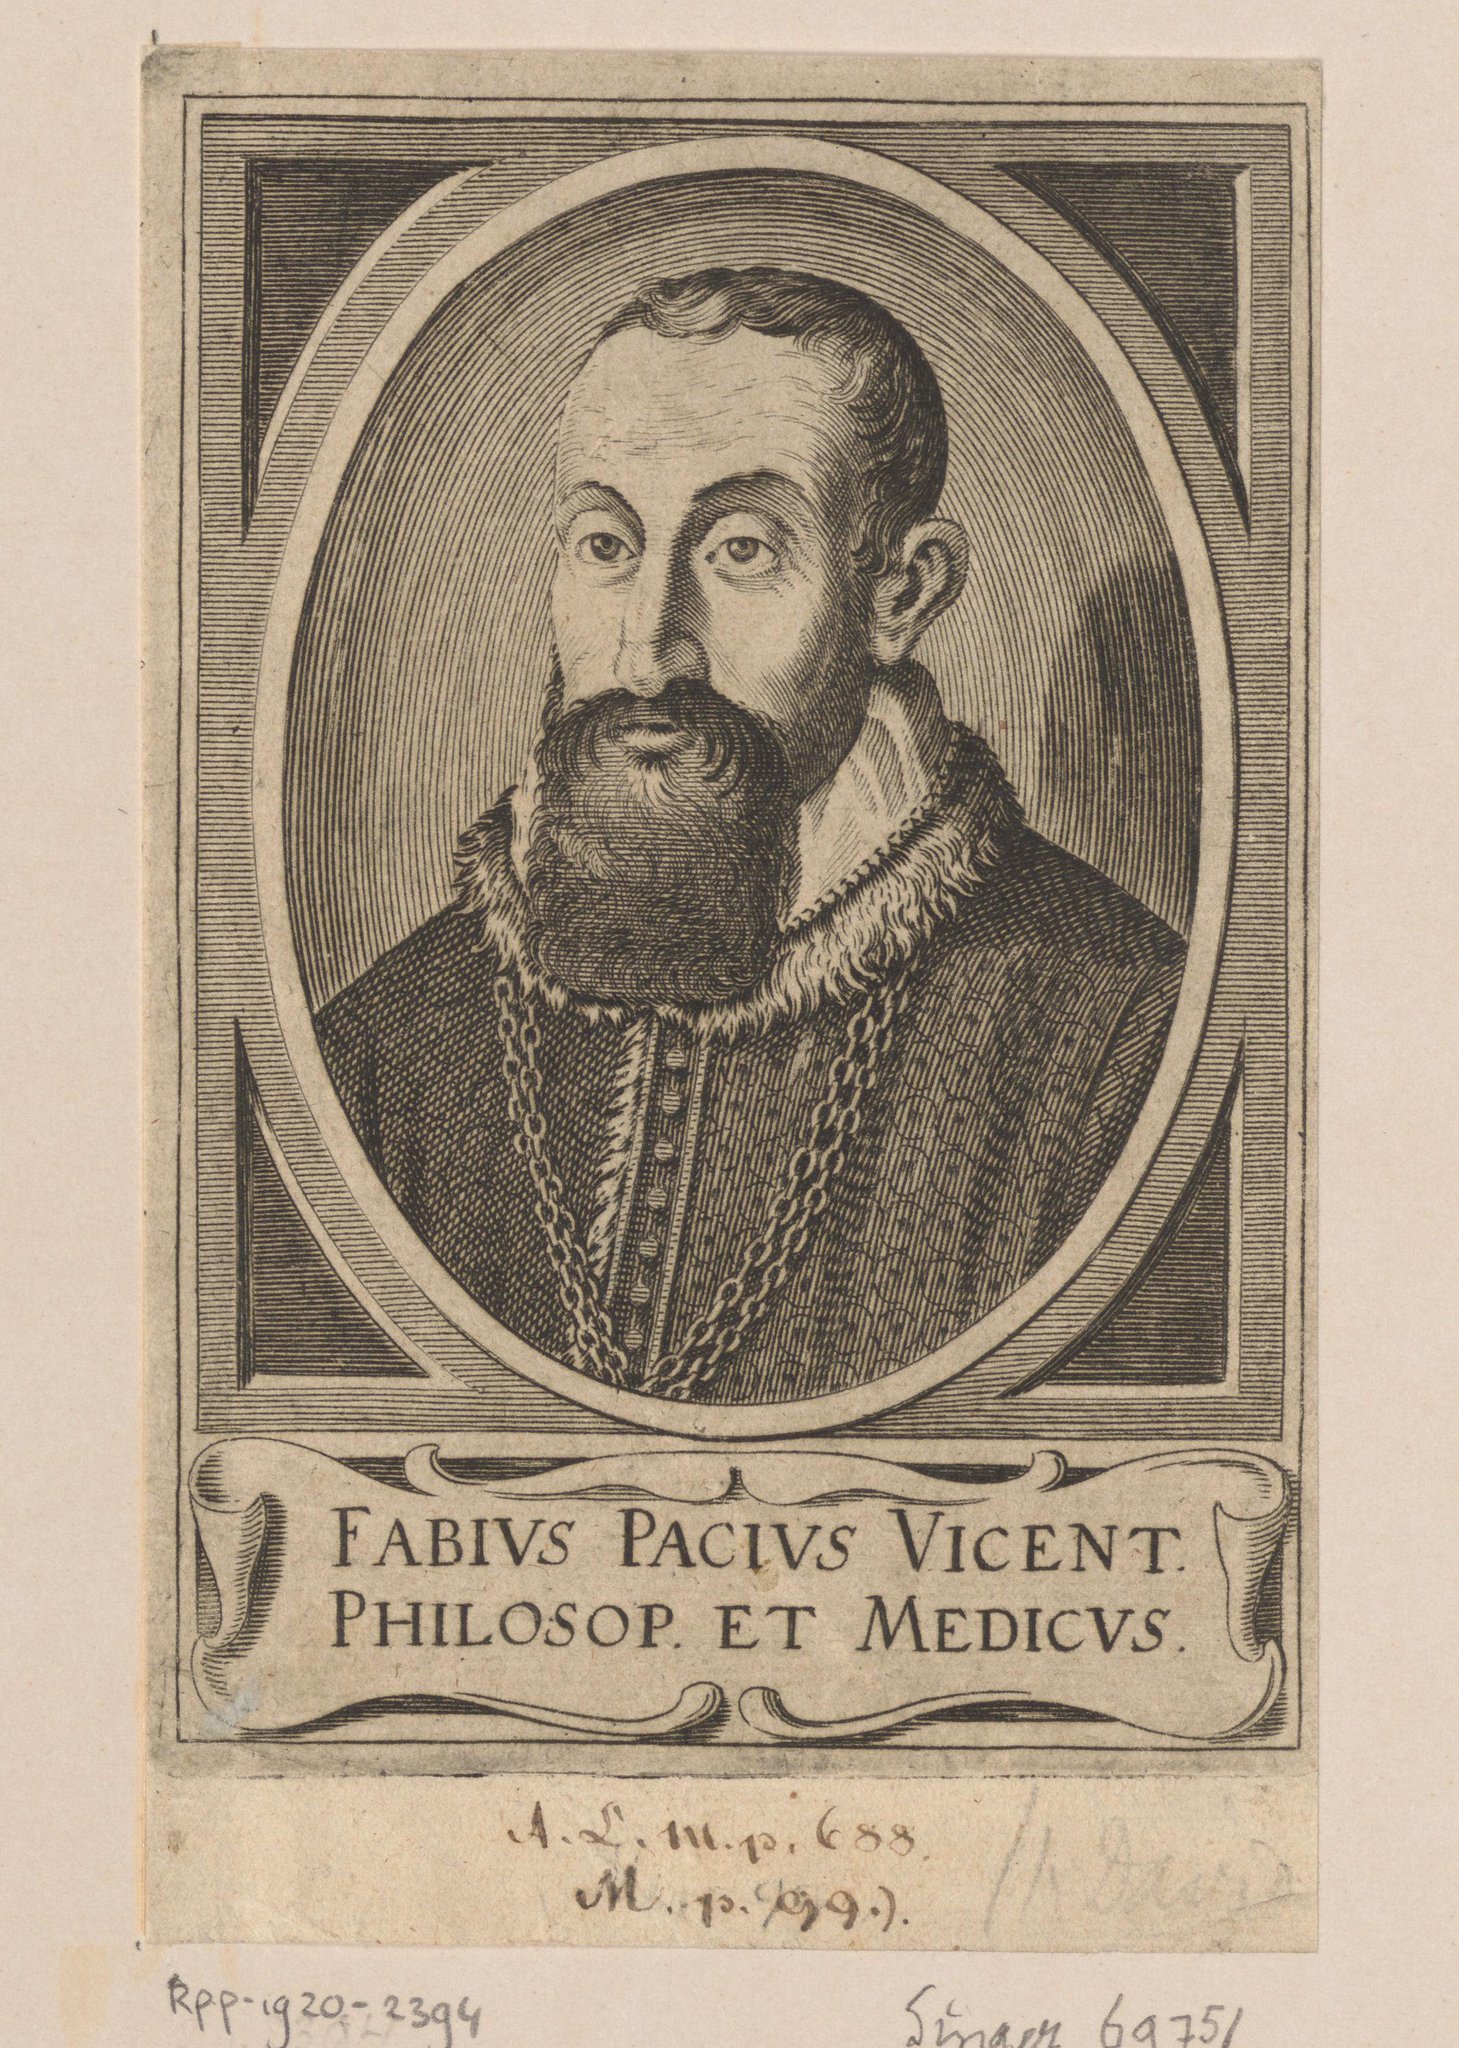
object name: print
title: Portret van Fabius Pacius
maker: Anonymous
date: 1644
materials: paper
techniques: engraving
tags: adult man, historical persons, beard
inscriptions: inscription: ‘A.L.m.p. 688/ M.p. 99.)’, collector's mark: Lugt 2228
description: Prent met tekst op verso gebruikt in: Tomasini, Giacomo Filippo. Elogia virorum literis & sapientia illustrium ad viuum expressis imaginibus exornata (...). Padua: Sebastiano Sardi, 1644.